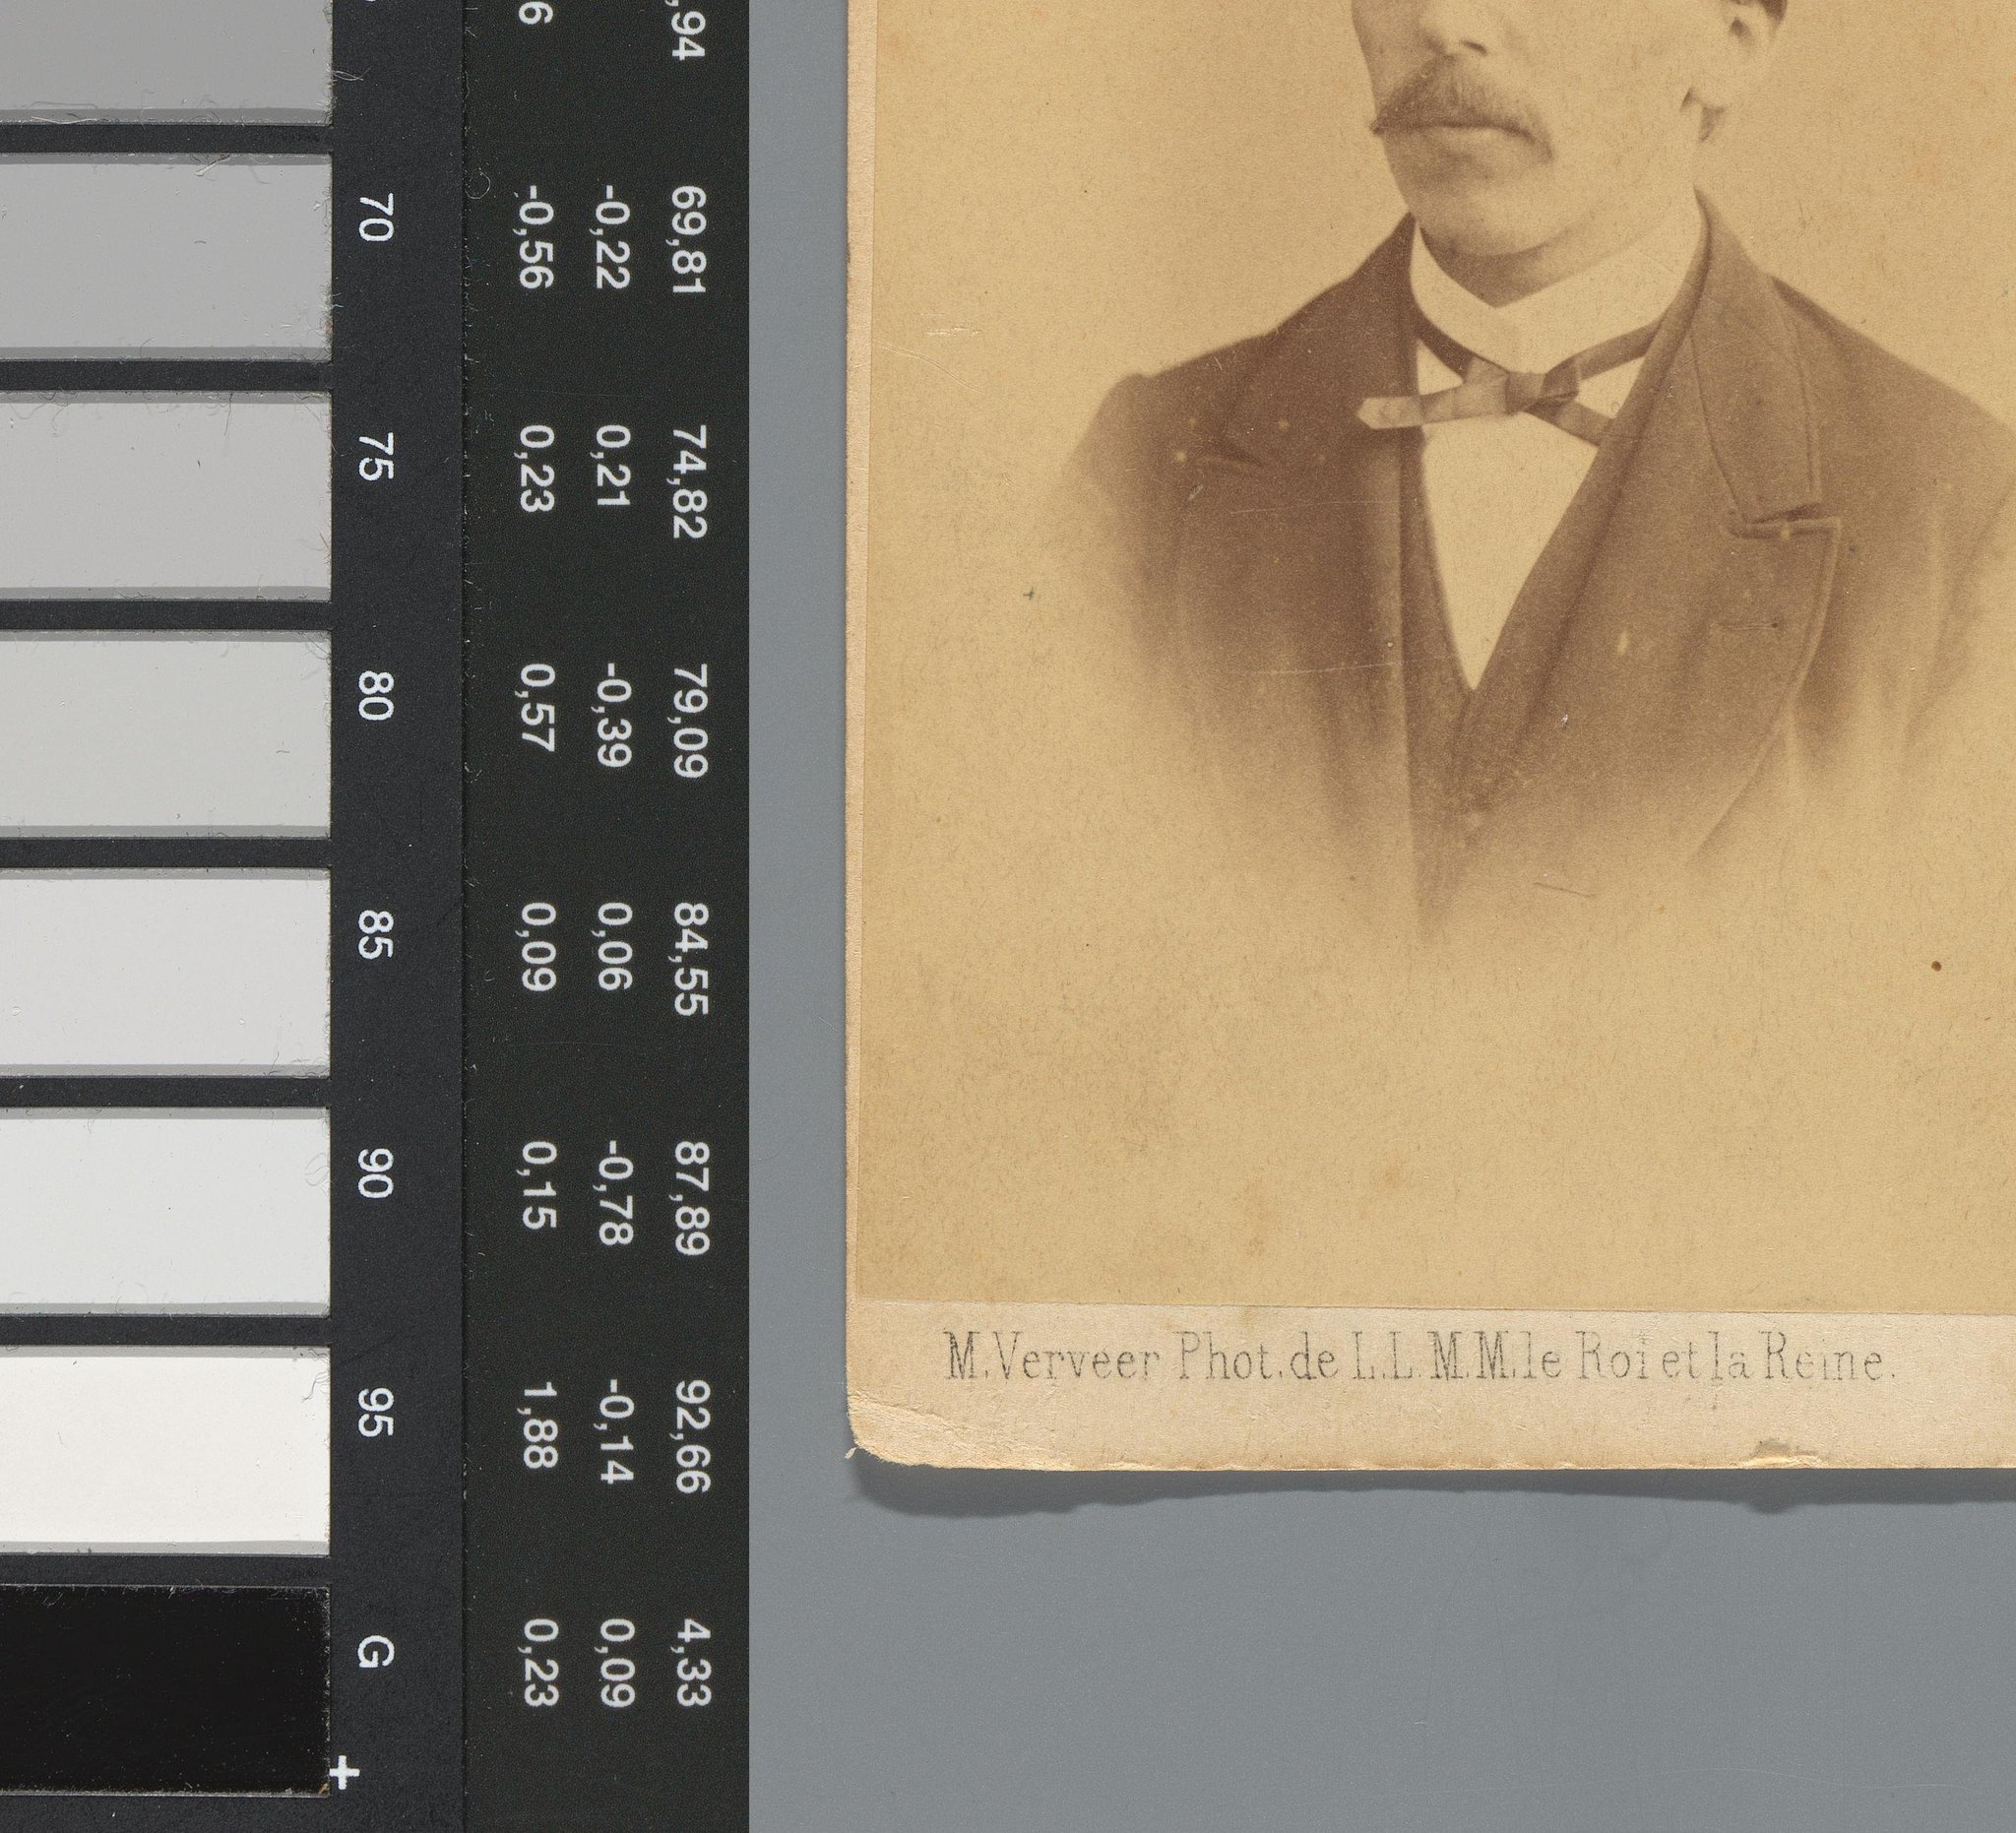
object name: carte de visite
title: Portret van Carolus Petrus van den Berg (Charles)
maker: maurits verveer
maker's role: painter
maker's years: 1817-1903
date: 1855-1910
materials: cardboard, photographic support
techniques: albumen print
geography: the hague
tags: utrecht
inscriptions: name: ‘M. VERVEER / Photographe / de L.L.M.M. le Roi et la Reine des Pays-Bas / 52 ZEESTRAAT 52 / VIS A VIS DU WILLEMSPARK / LA HAYE’, inscription: ‘oom Charles / van den Berg / 1840 - / 1881’, name: ‘M. Verveer Phot. de L.L.M.M. le Roi et la Reine’